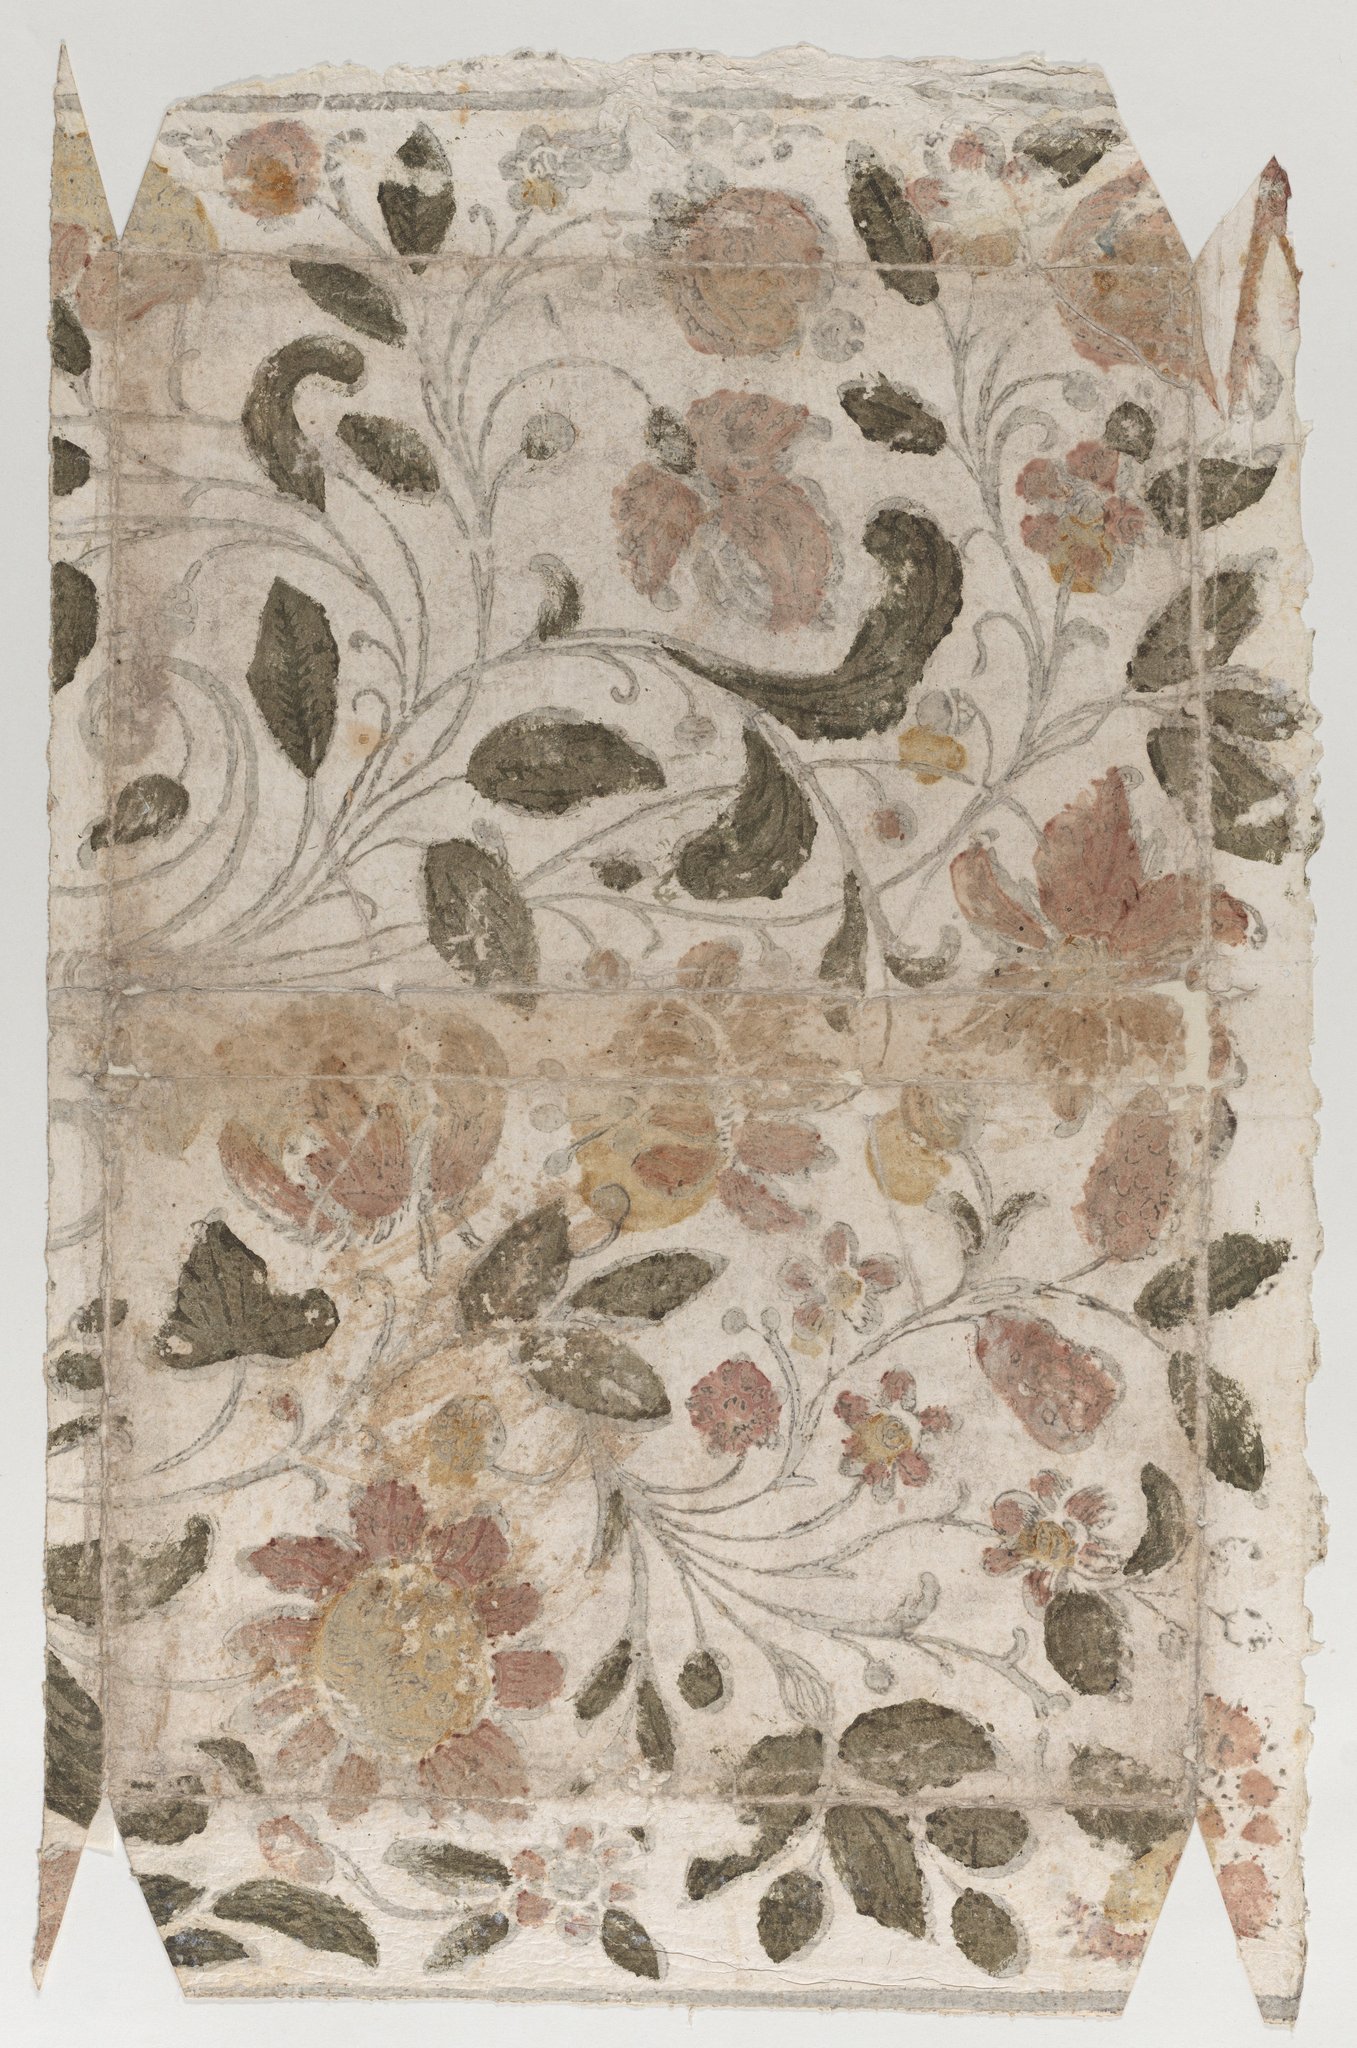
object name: print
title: Book cover with overall floral pattern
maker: Anonymous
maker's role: artist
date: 1701-1800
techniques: relief print